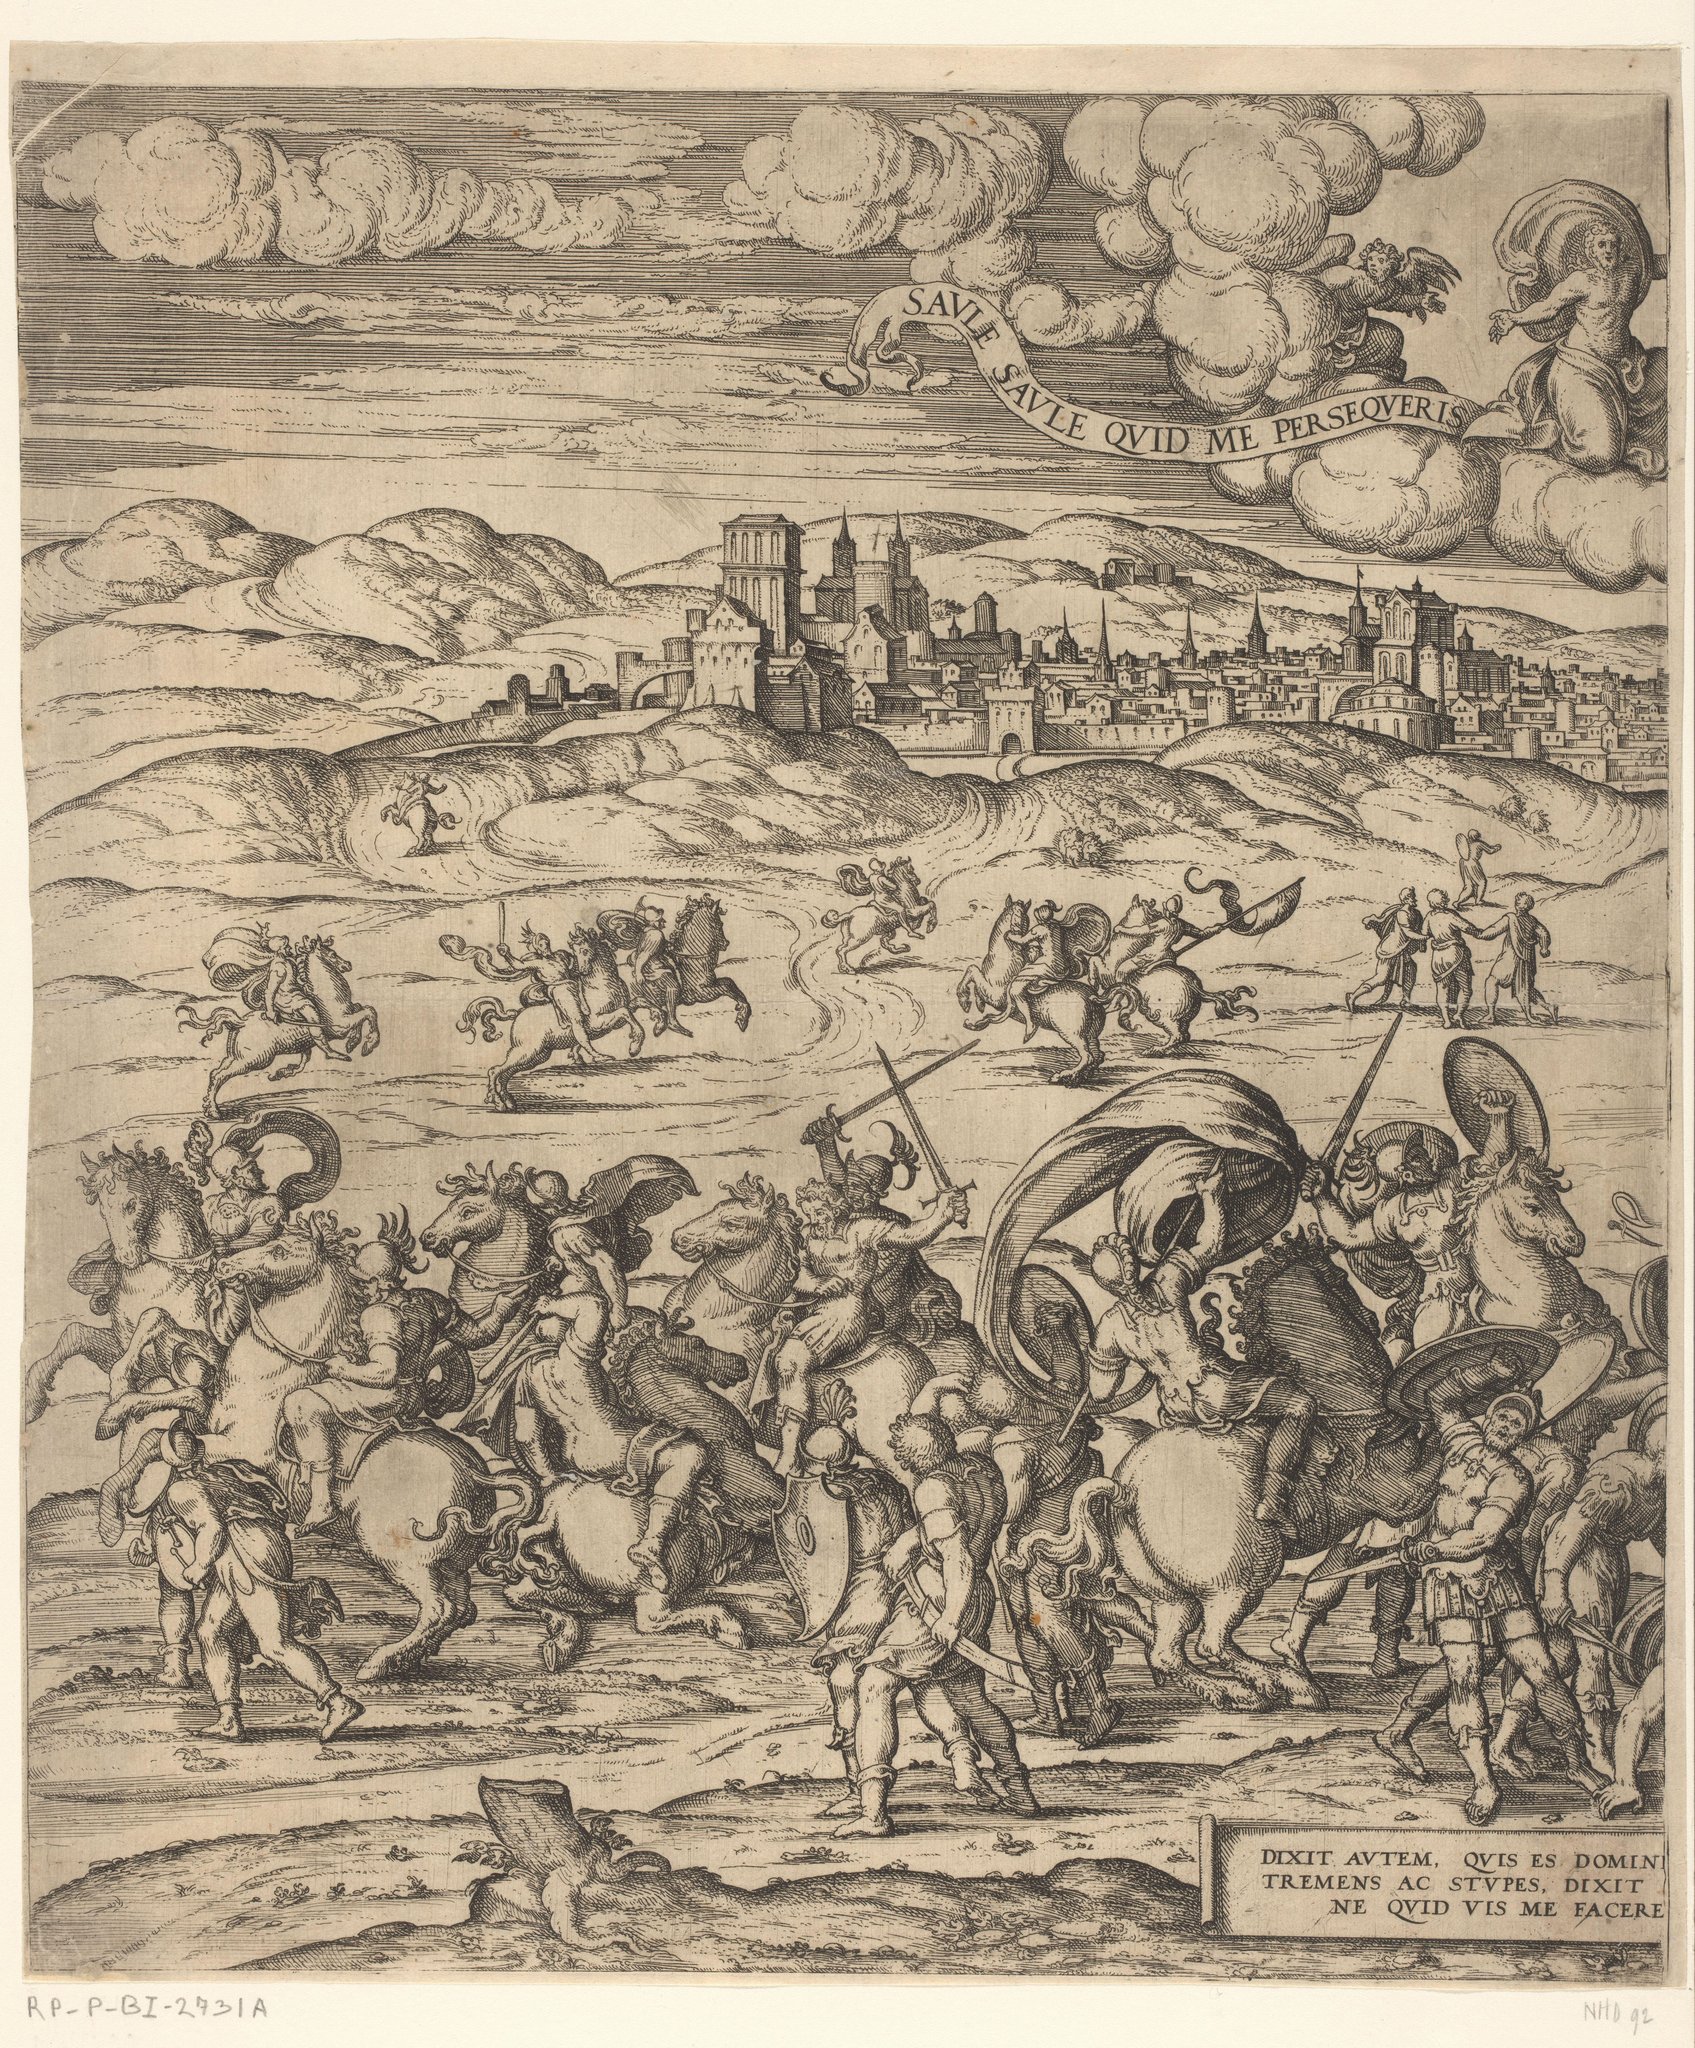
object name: print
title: Bekering van Paulus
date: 1545-1608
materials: paper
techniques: engraving, etching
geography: italy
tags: on the way to damascus christ appears to saul, who falls from his horse and is blinded by the light, blind saul is led to damascus, single combat in place of battle (+ cavalry, horsemen)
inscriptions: collector's mark: Lugt 240 of 1838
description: Linkerplaat. Romeinse soldaten bevechten elkaar buiten de stad Damascus. Paarden raken in paniek. Paulus staat in het midden van de prent en wordt door zijn metgezellen begeleid naar de stad (Handelingen 9:8). Centraal bovenaan verschijnt Christus uit de wolken met twee engelen. Twee banderoles naast Christus citeren Handelingen 9:4-5. Een banderole centraal onderaan citeert verder uit Handelingen 9.